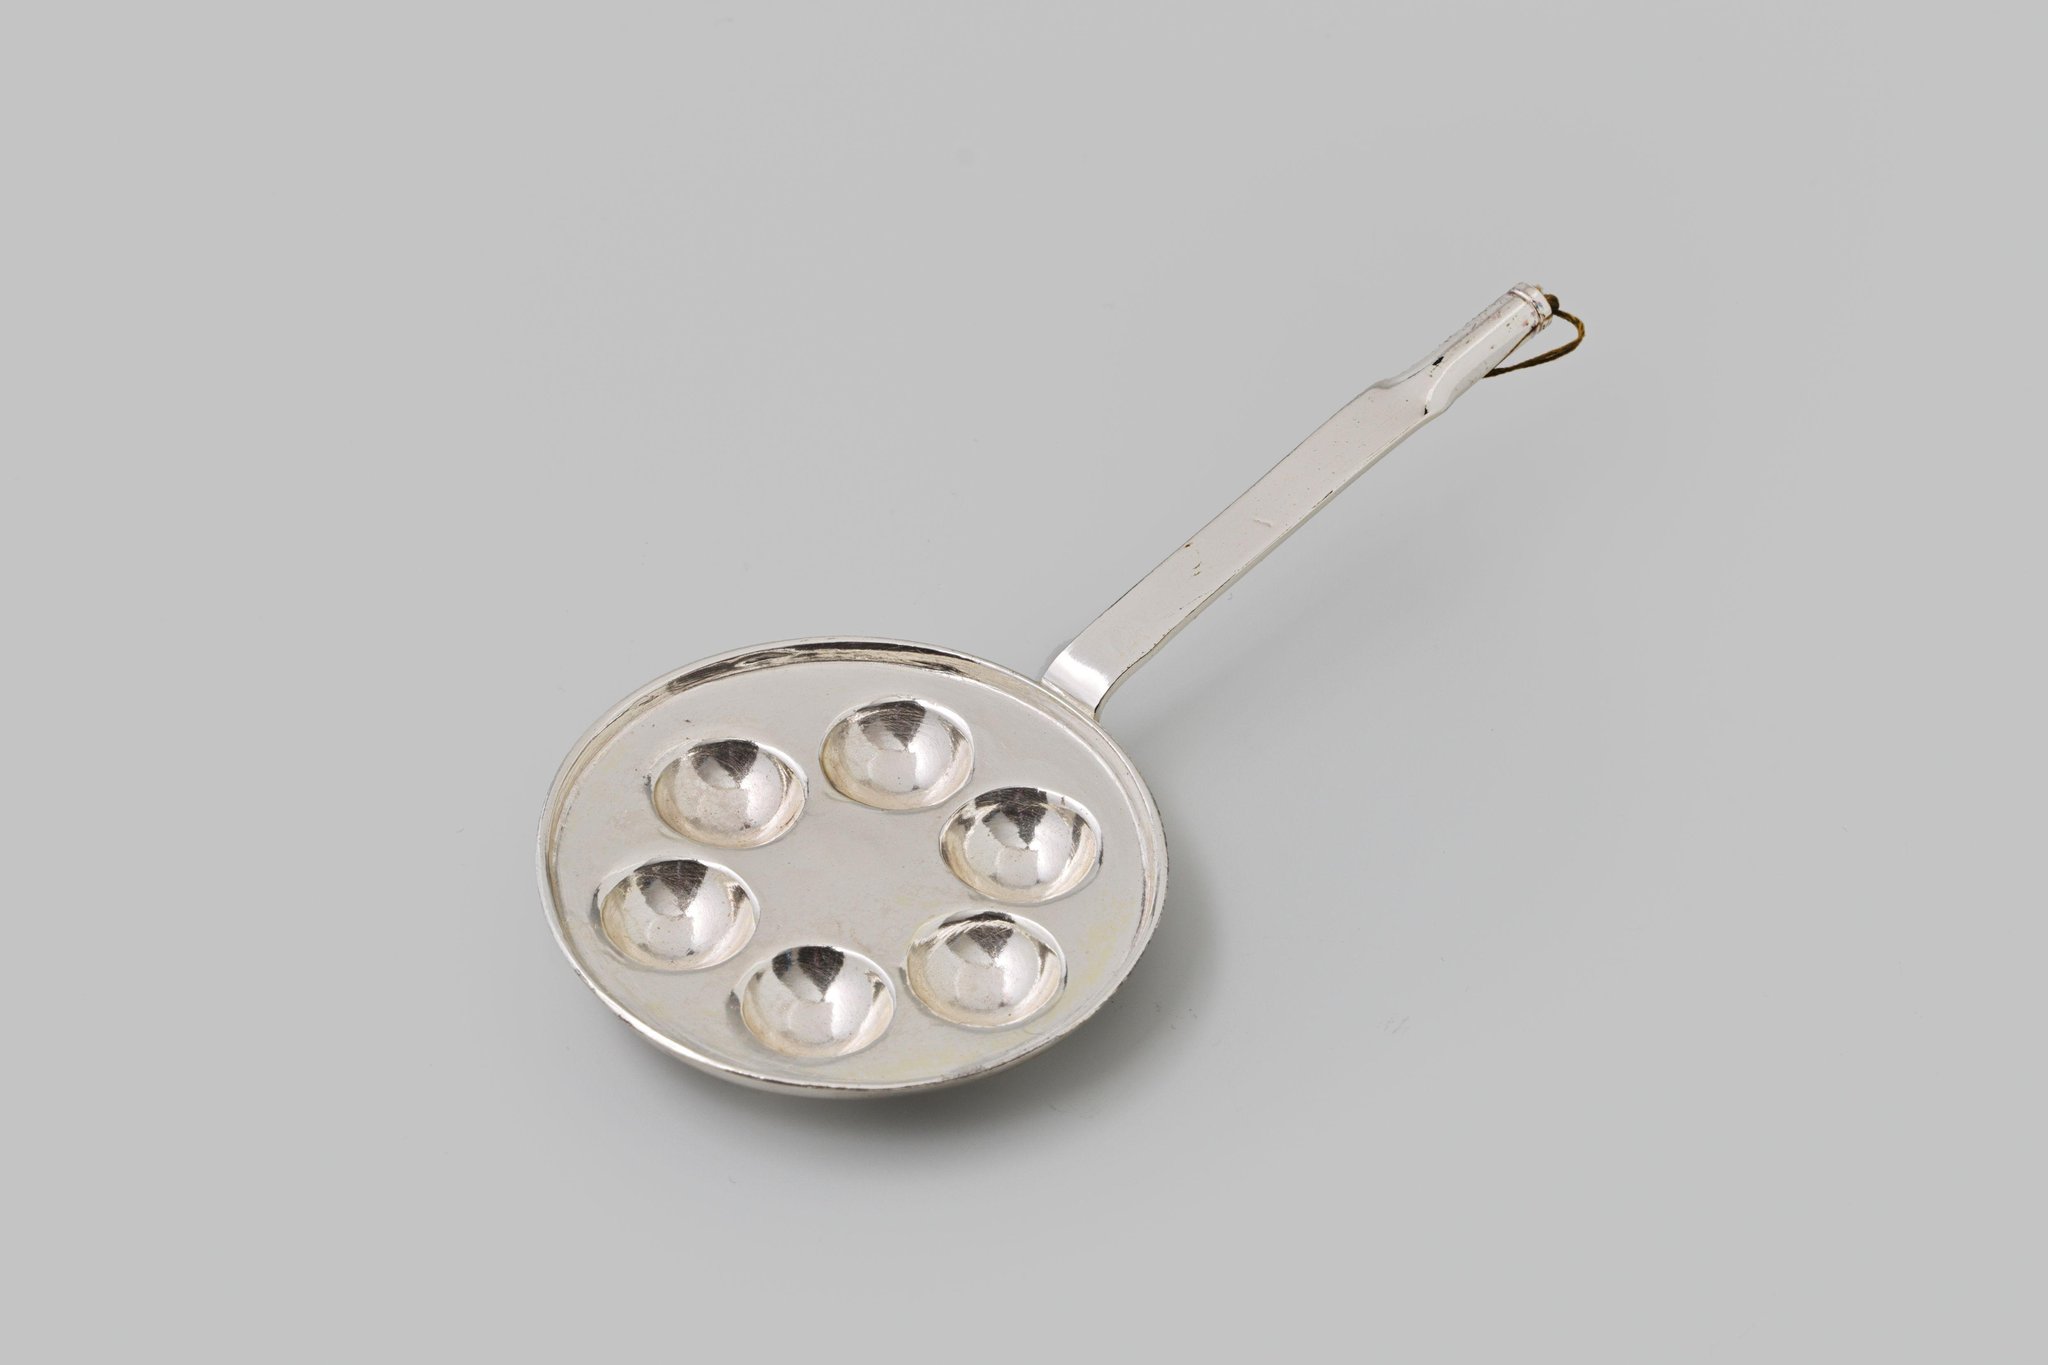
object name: evenveeltjespan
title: Miniatuurevenveeltjespan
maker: johannes adrianus van geffen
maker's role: silversmith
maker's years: 1734-1798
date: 1770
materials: silver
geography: amsterdam